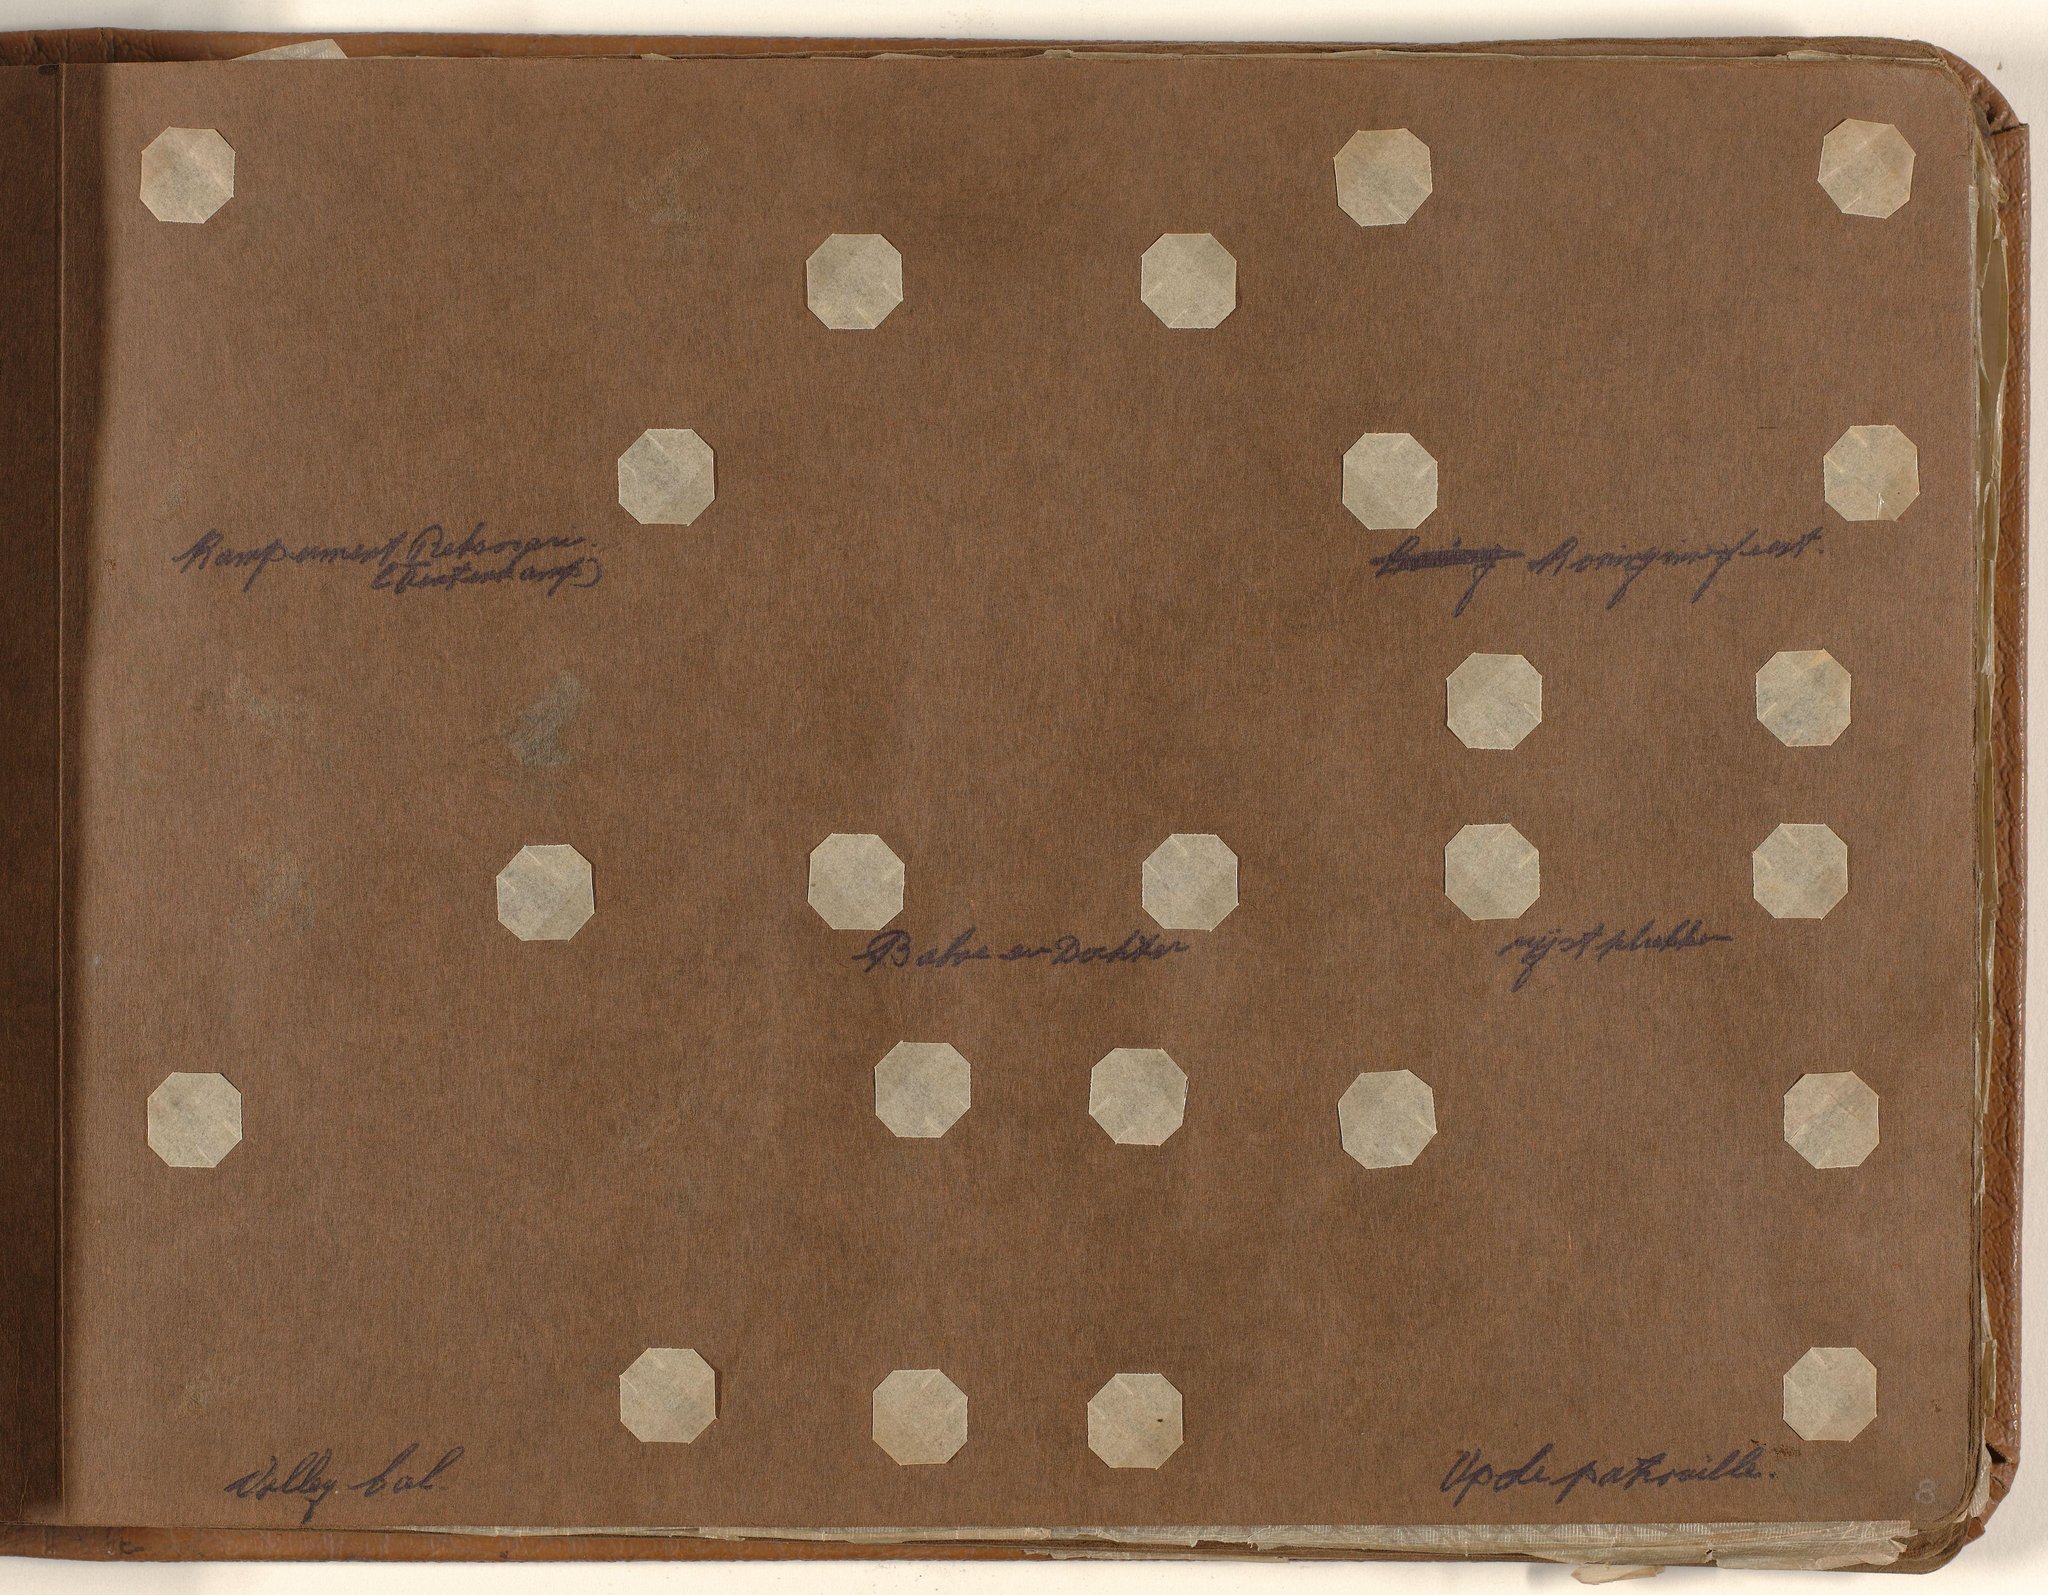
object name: album leaf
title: Enkel opschriften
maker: Anonymous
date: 1948-1949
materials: paper, photographic support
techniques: photography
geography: reksosari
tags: tijgerbrigade, reksosari, nederlandse militaire acties in indonesië (1945-1949)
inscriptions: annotation: ‘Tentenkamp Reksosari//Koninginnenfeest//Baboe en dochter// rijst plukken//Vollybal//Op de patrouille’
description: Albumblad zonder foto's maar met zes opschriften.